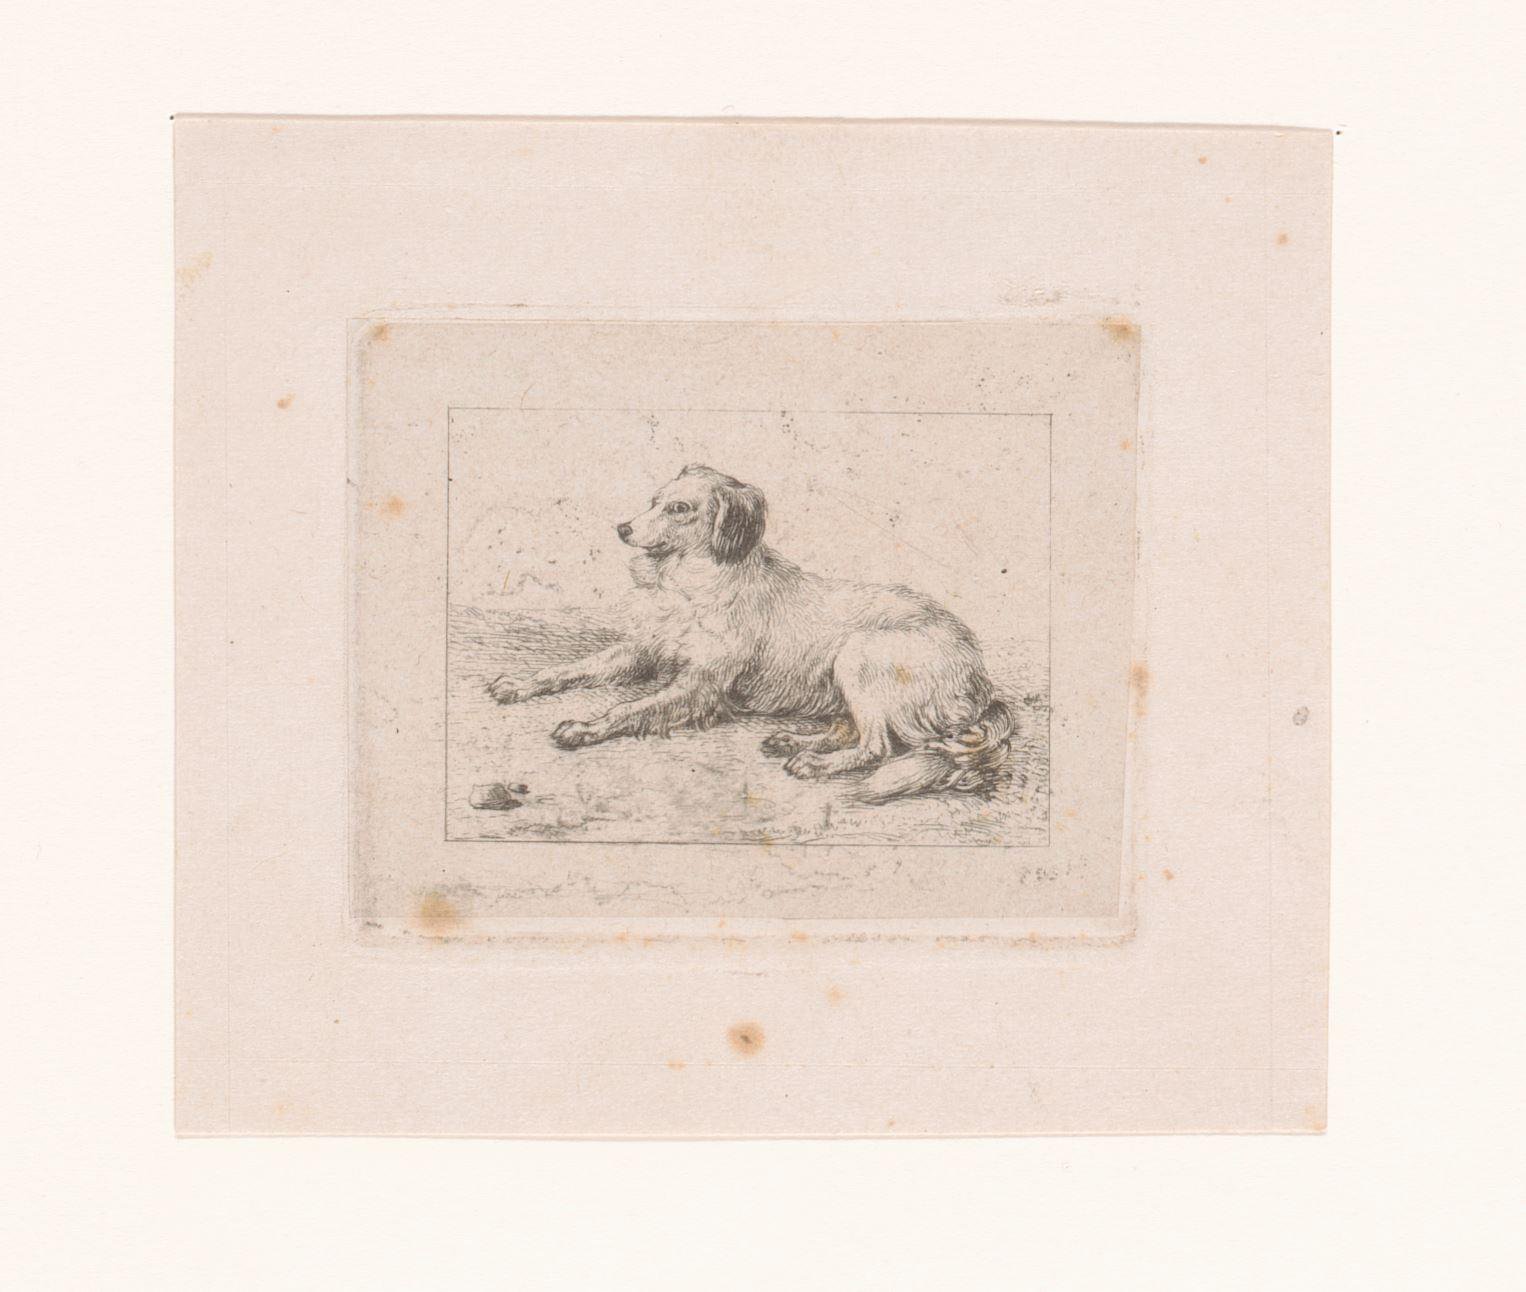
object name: print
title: Liggende spaniël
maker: eugène verboeckhoven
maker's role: draughtsman, painter, print maker, printer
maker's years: 1798-1881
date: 1830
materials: paper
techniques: etching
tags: dog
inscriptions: collector's mark: Lugt 2228, collector's mark: Lugt 1485